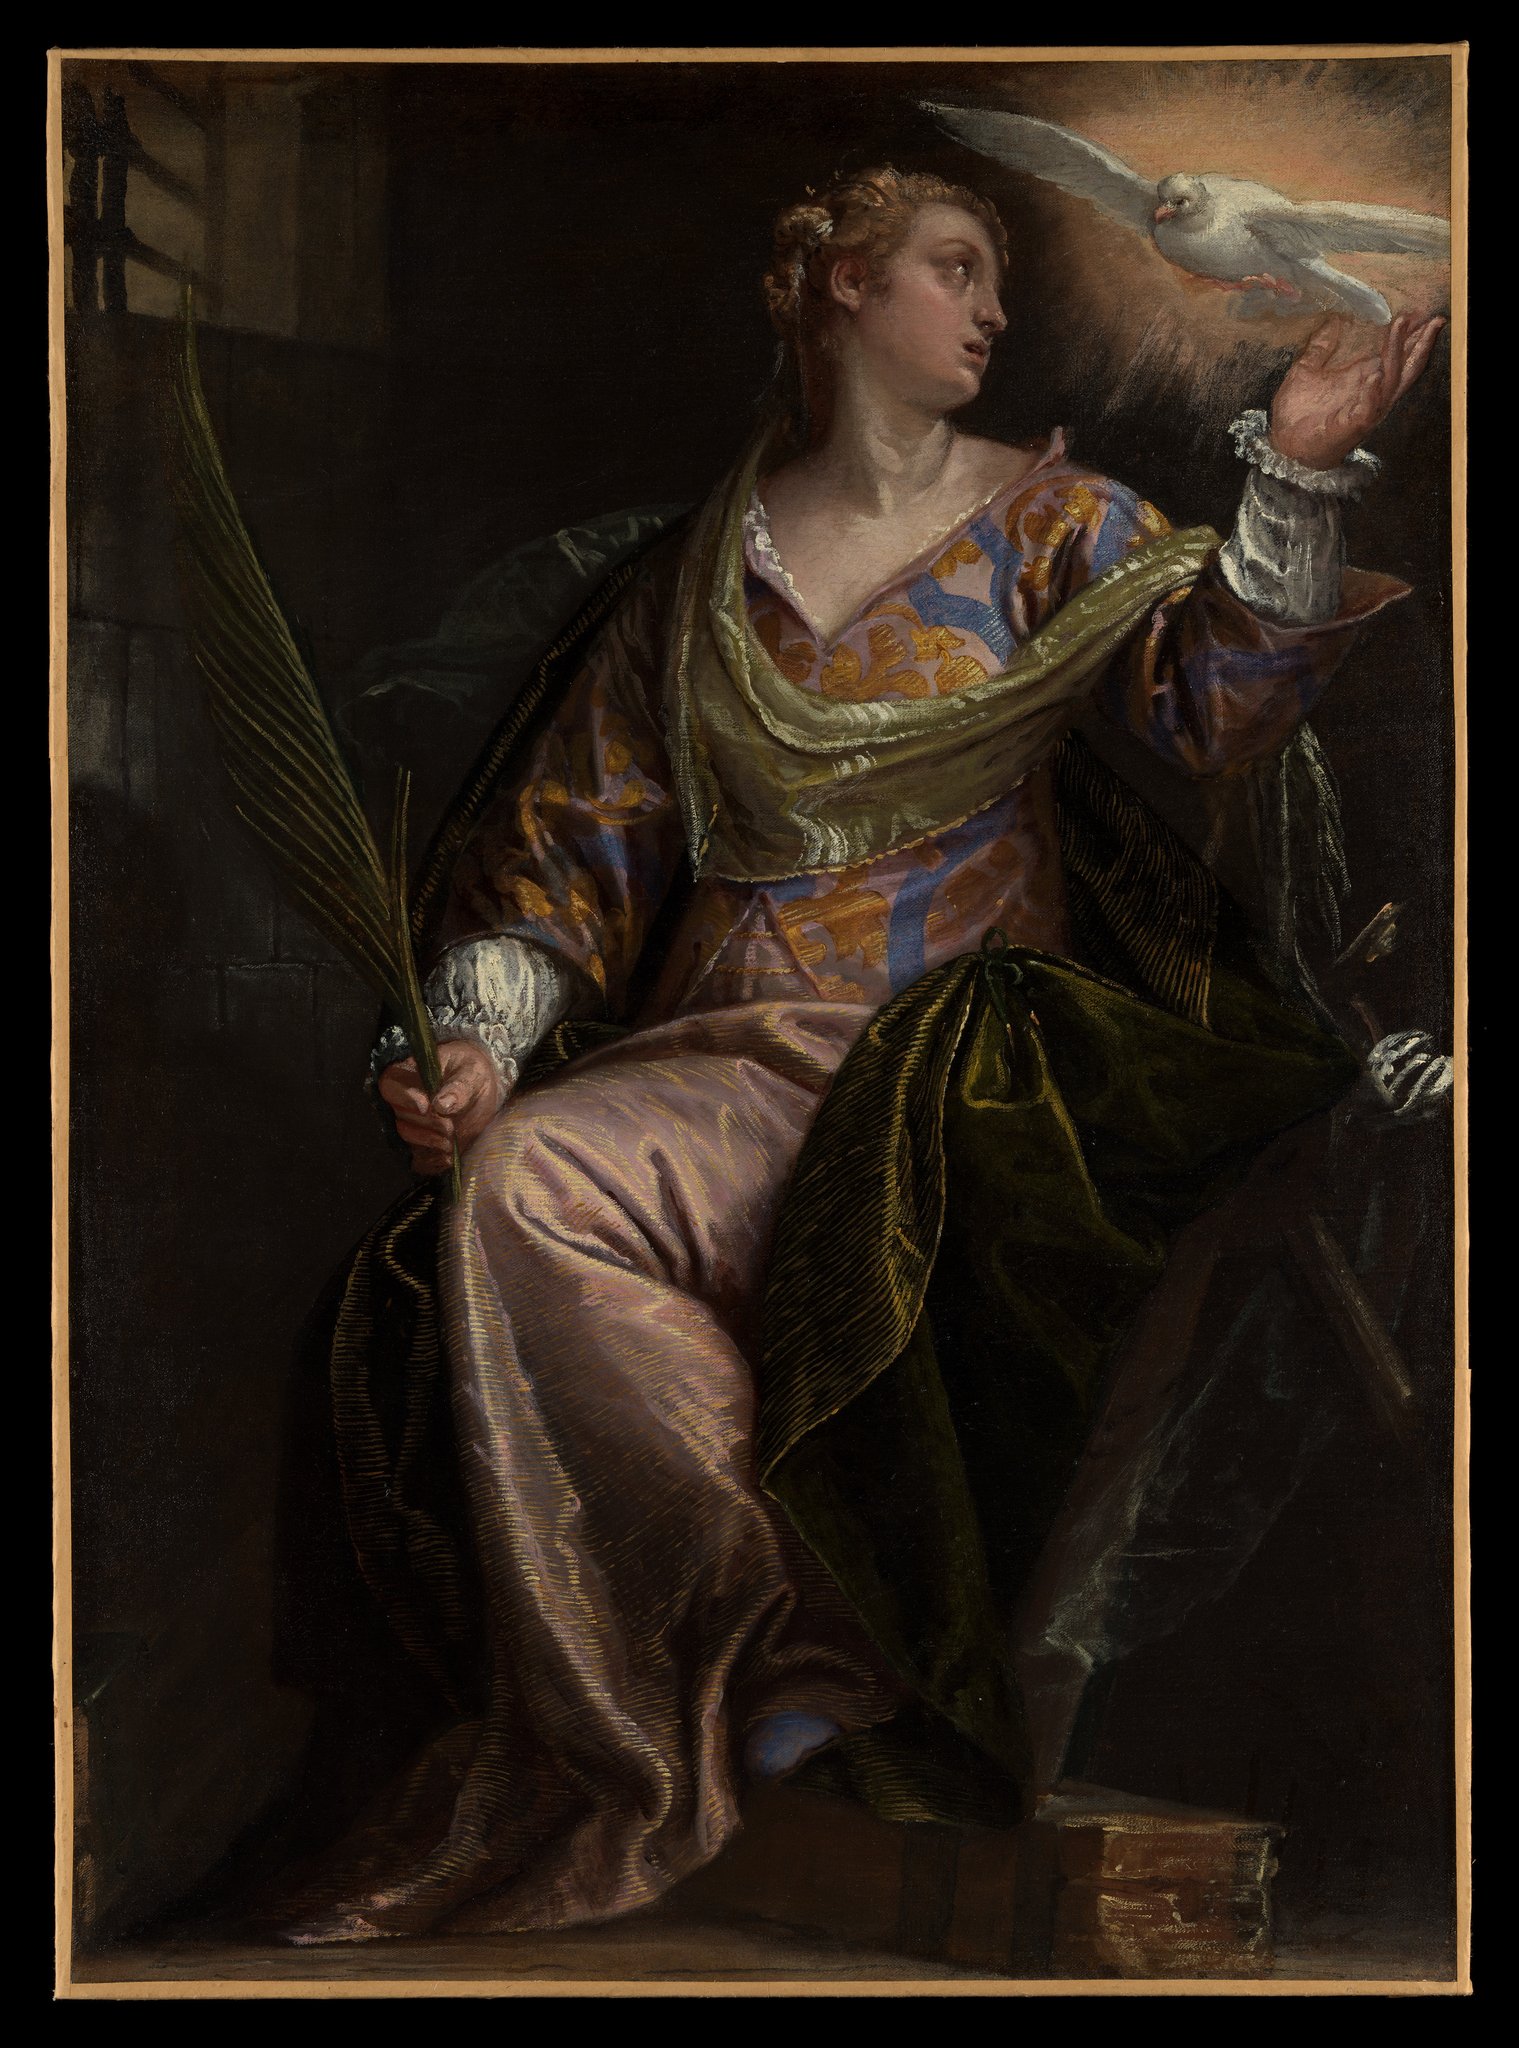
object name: painting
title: Saint Catherine of Alexandria in Prison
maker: paolo veronese (paolo caliari)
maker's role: artist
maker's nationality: italian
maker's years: 1528-1588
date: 1585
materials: canvas, oil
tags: doves,prisons,palms,saint catherine